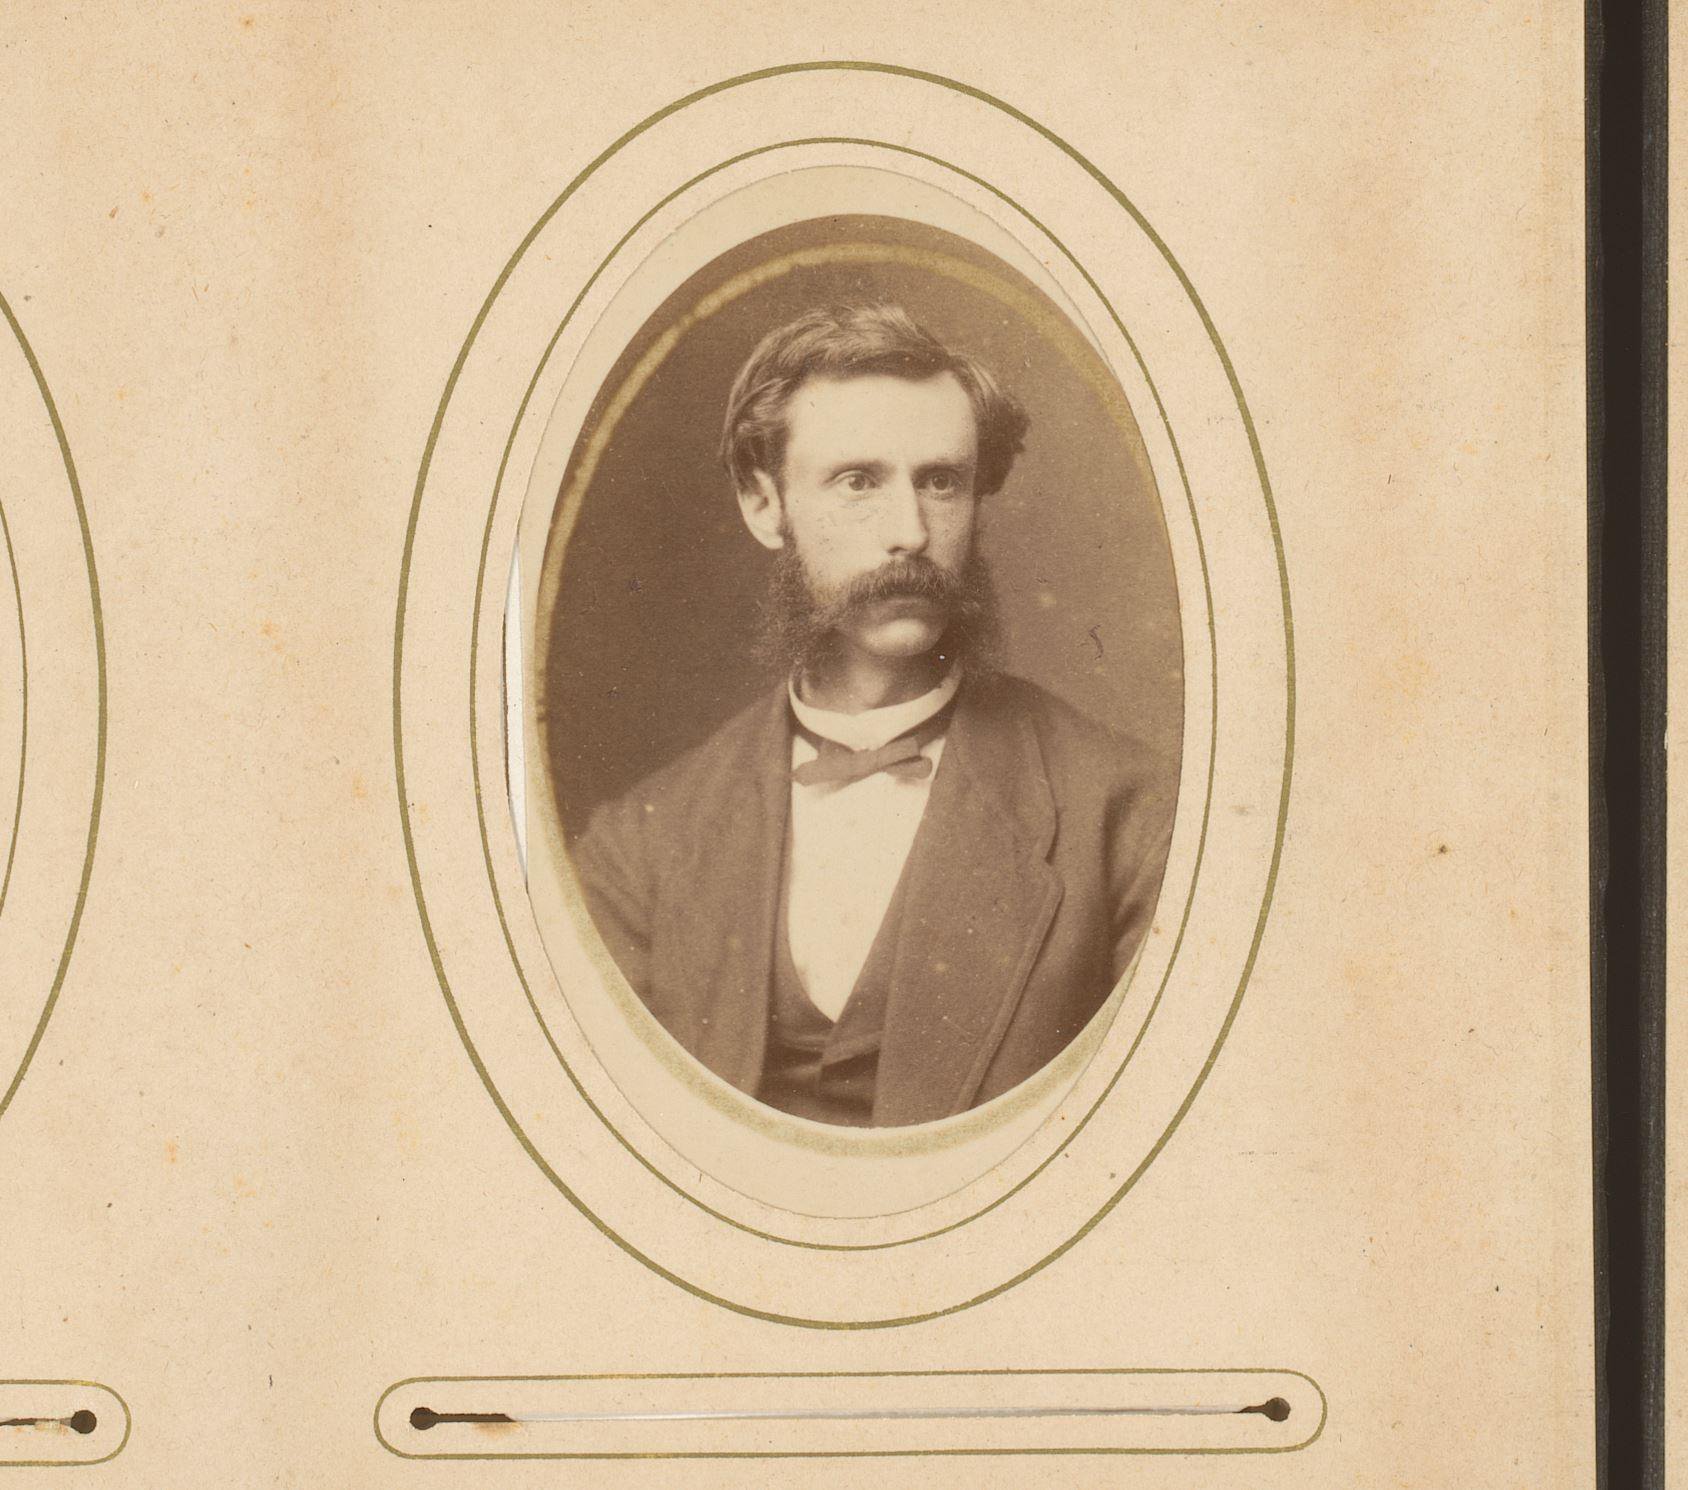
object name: album leaf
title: Portret van een man met snor en bakkebaarden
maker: johannes baer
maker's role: fotograaf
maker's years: 1840-1912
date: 1873-1891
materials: cardboard, photographic support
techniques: albumen print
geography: rotterdam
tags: sideburns, moustache, historical persons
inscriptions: inscription: ‘Photographie/ J. Baer/ Rotterdam/ Schiedamsche Singel/ 55.’